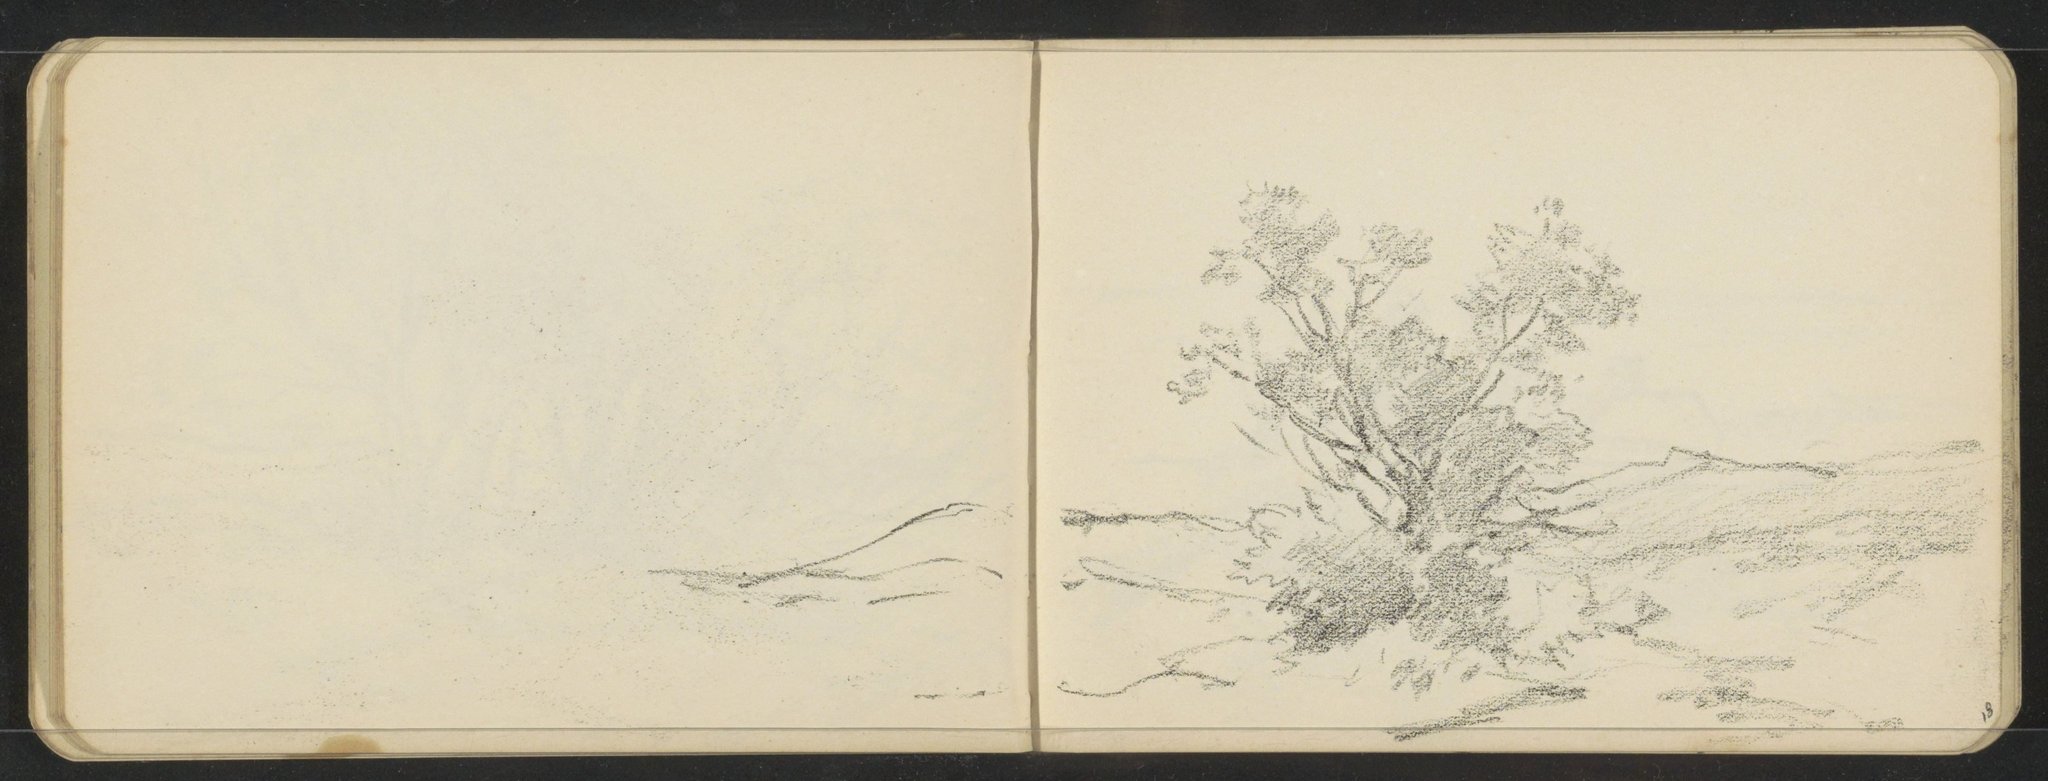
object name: sketchbook leaf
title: Landschap met boom, vermoedelijk te Bloemendaal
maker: willem cornelis rip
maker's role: draughtsman, painter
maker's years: 1856-1922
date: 1914-1916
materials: chalk, paper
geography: bloemendaal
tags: landscapes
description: Blad 17 verso en 18 recto uit een schetsboek met 41 bladen.